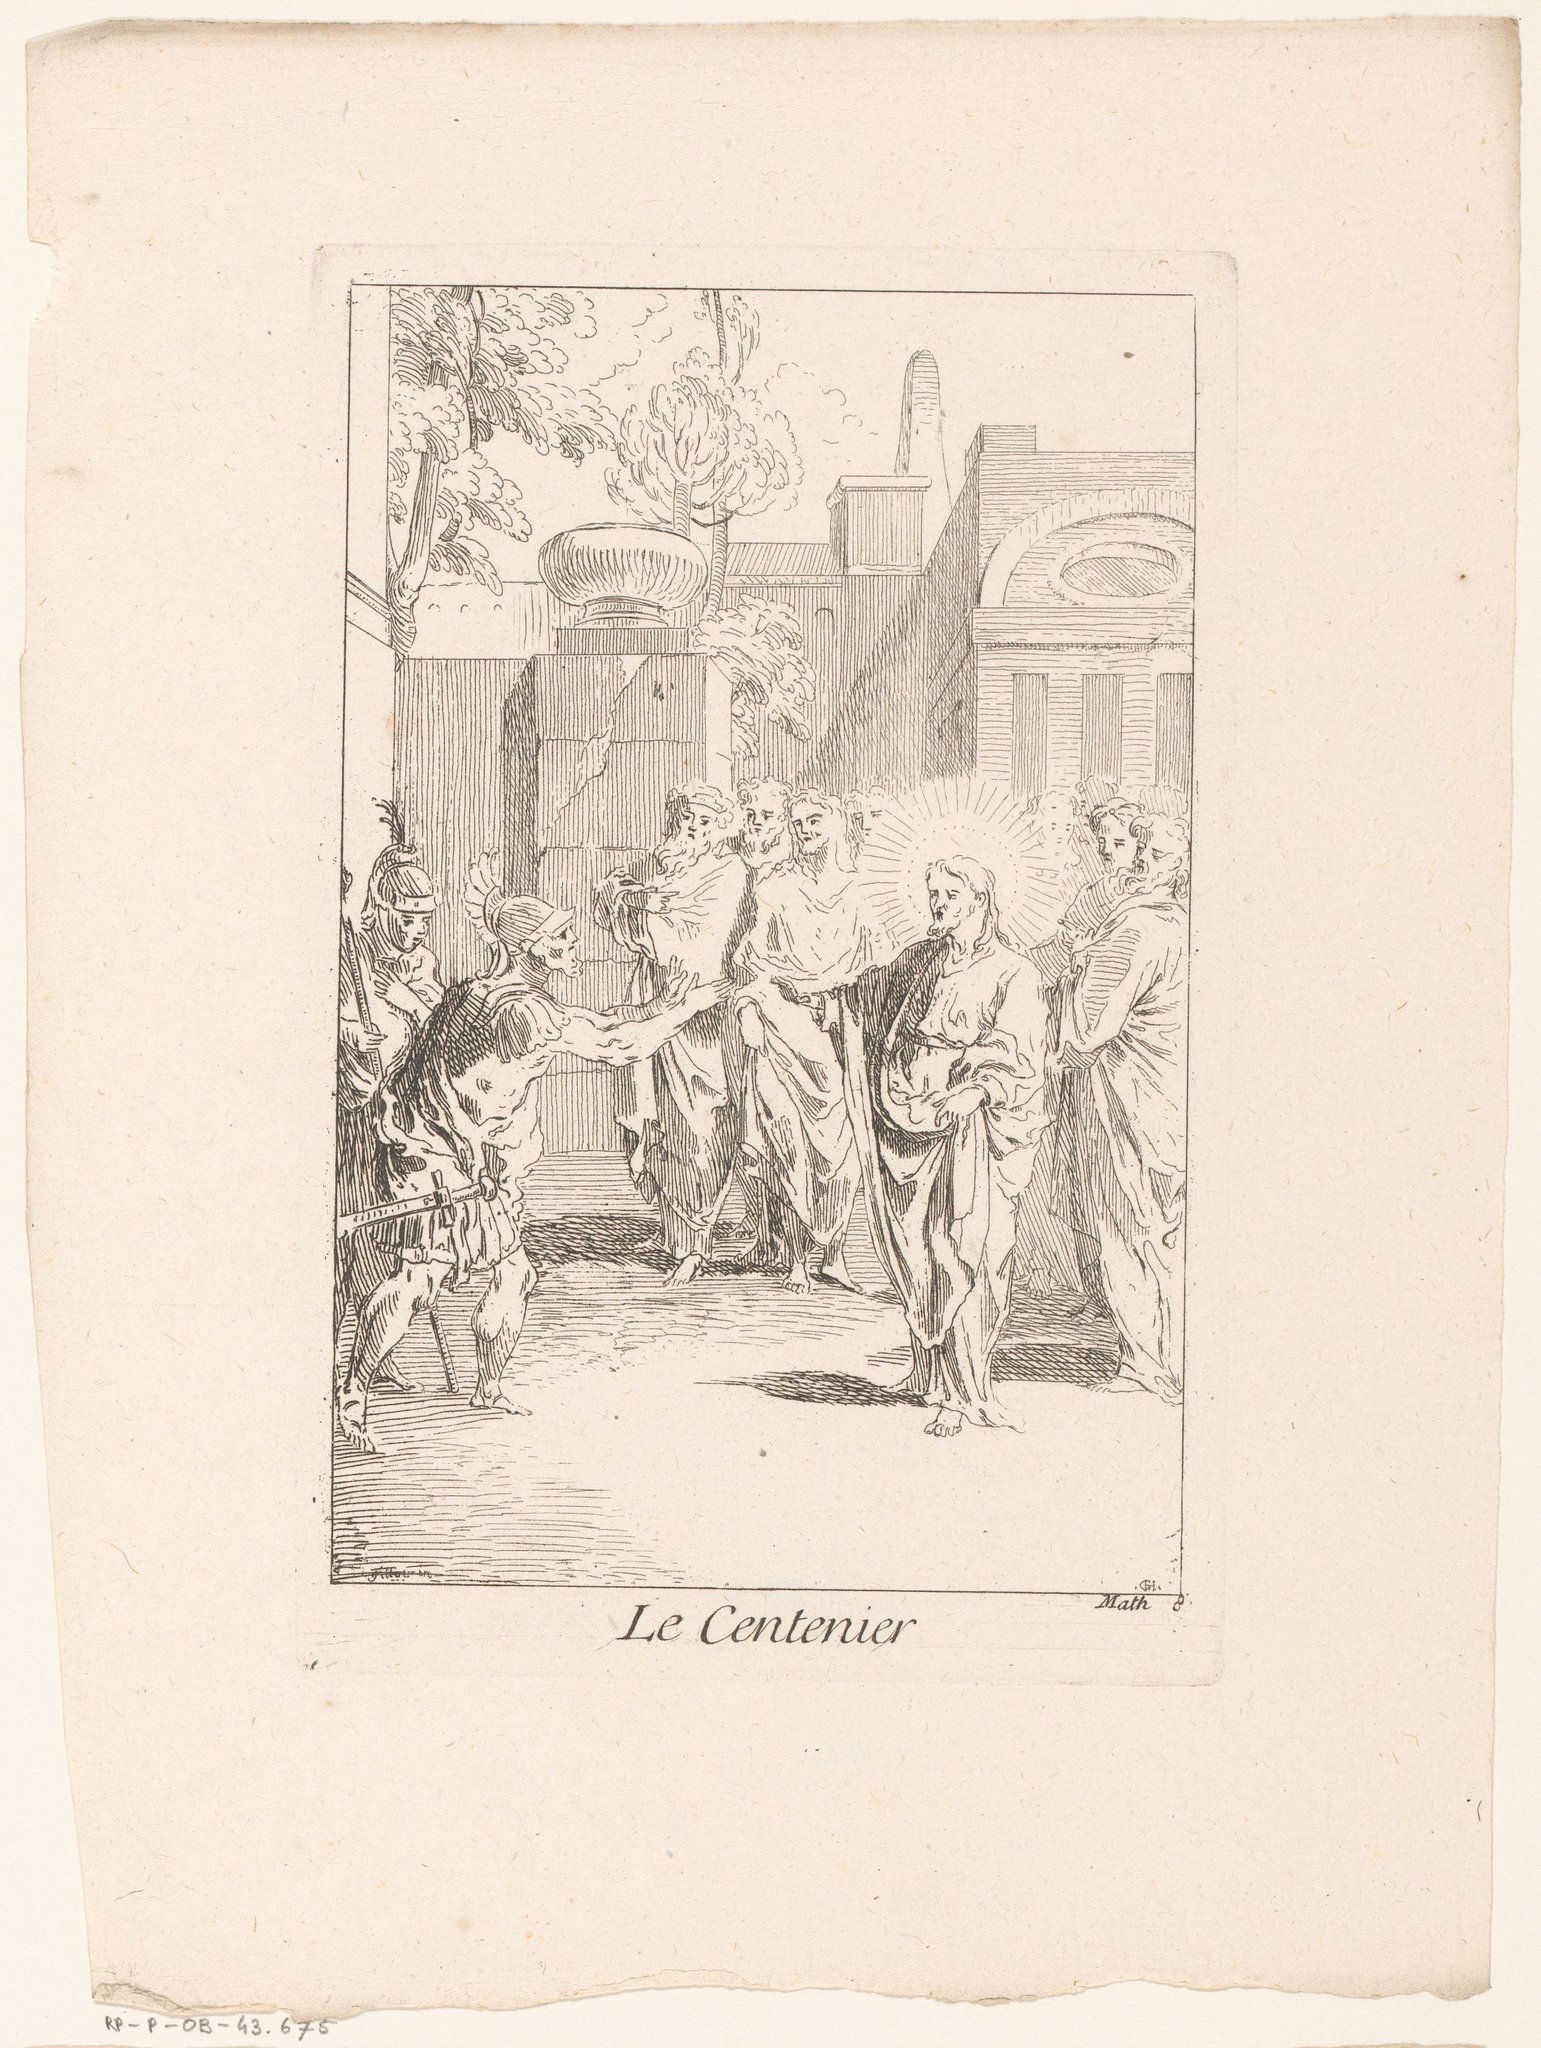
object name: print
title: Leven en passie van Christus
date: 1705-1732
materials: paper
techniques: etching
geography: france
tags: the centurion of capernaum, kneeling before christ, begs him to heal his paralytic servant (or son) (matthew 8:5-13; luke 7:1-10; john 4:46-54)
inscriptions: collector's mark: Lugt 2228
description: Maakt deel uit van een serie met zestig prenten met als thema het leven van Christus.